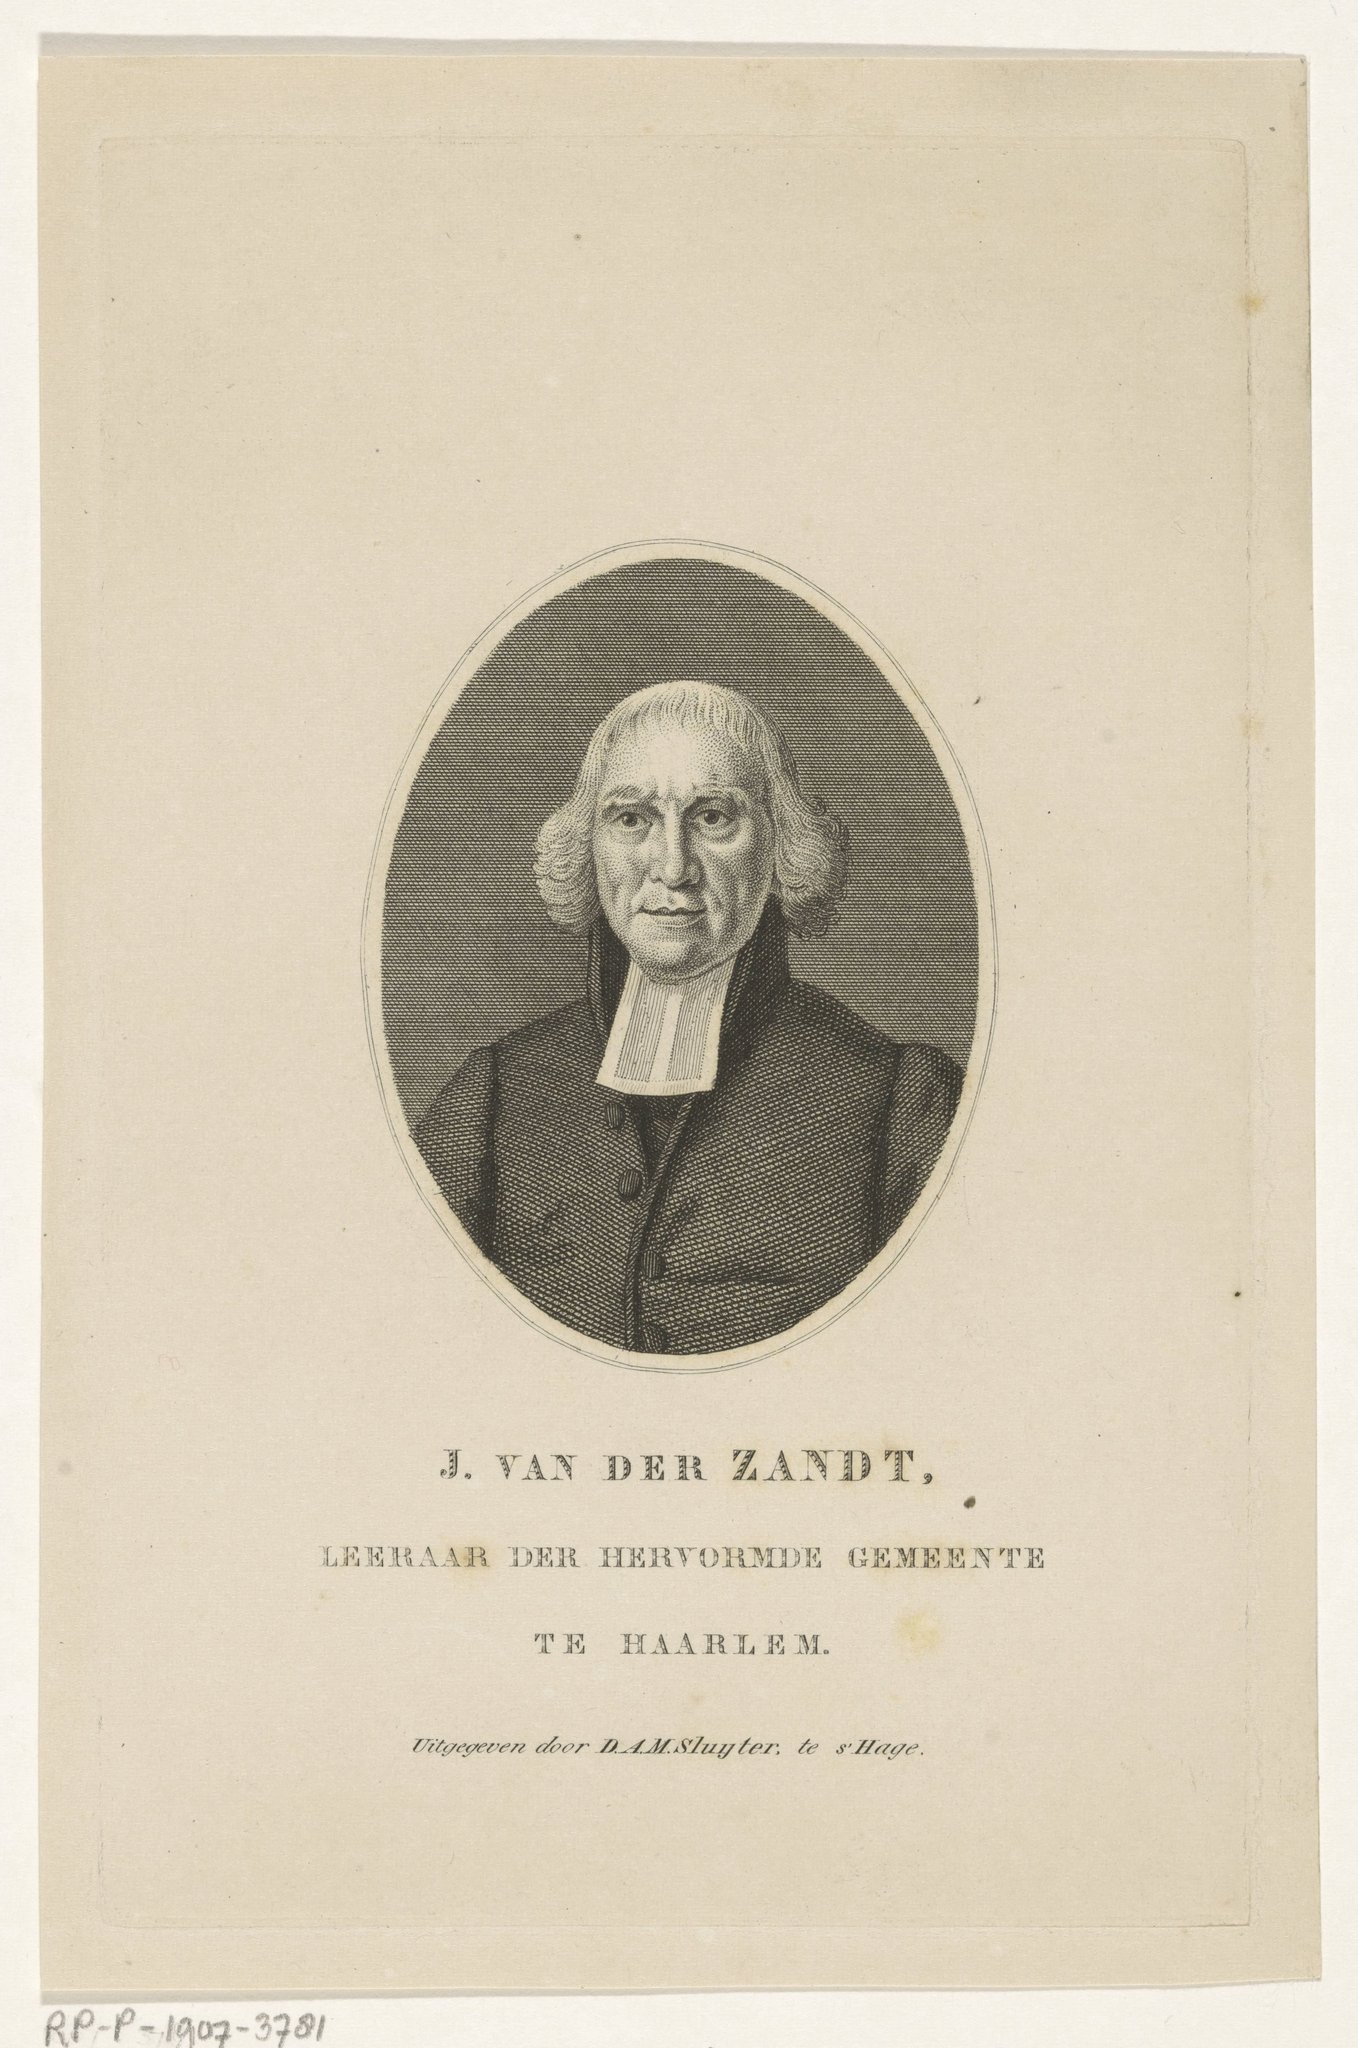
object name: print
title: Portret van Jan van der Zandt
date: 1800-1837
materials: paper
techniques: engraving, etching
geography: the hague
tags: predikant, jan van der zandt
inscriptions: collector's mark: Lugt 2228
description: Portret van Jan van der Zandt, Hervormd predikant te Haarlem, gekleed in een zwarte jas met witte bef. Buste naar links in ovaal. Onderaan in de marge een tweeregelige tekst in het Nederlands.